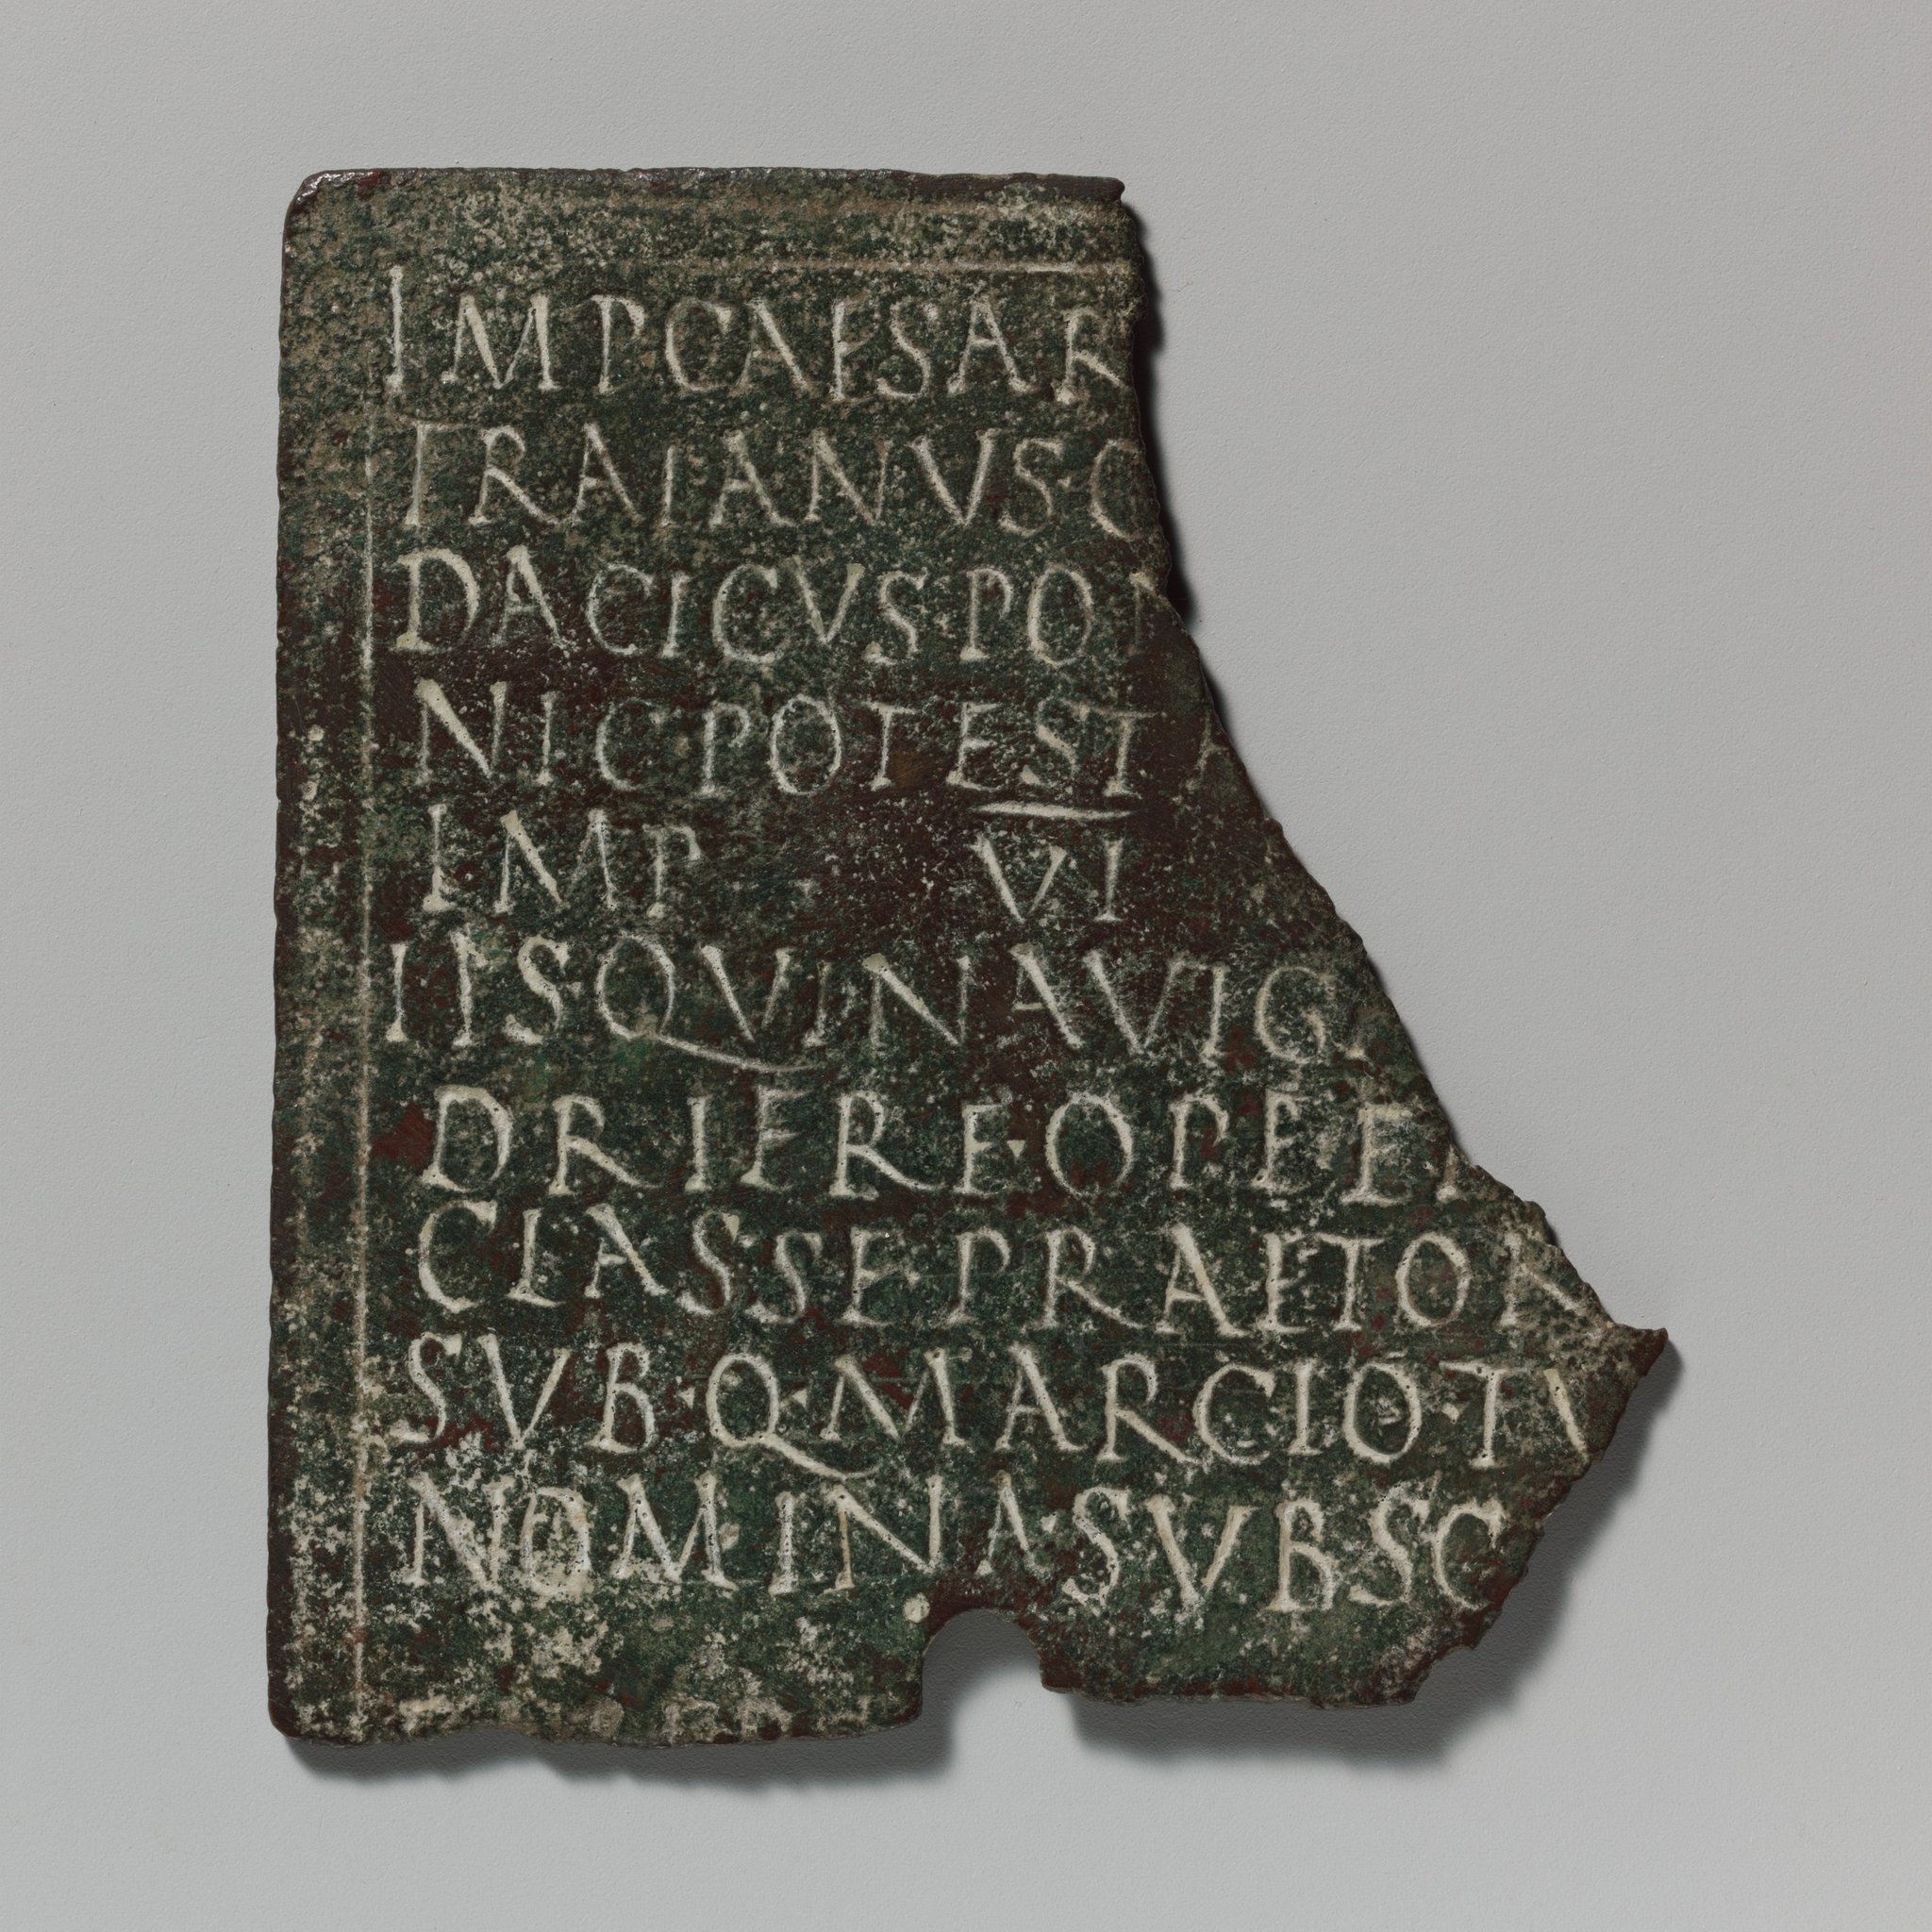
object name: military diploma fragment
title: Bronze military diploma fragment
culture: roman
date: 113-114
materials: bronze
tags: documents